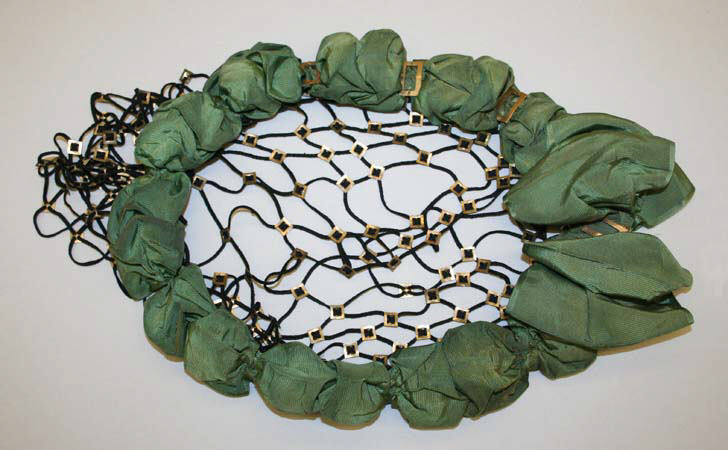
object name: snood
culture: european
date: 1860